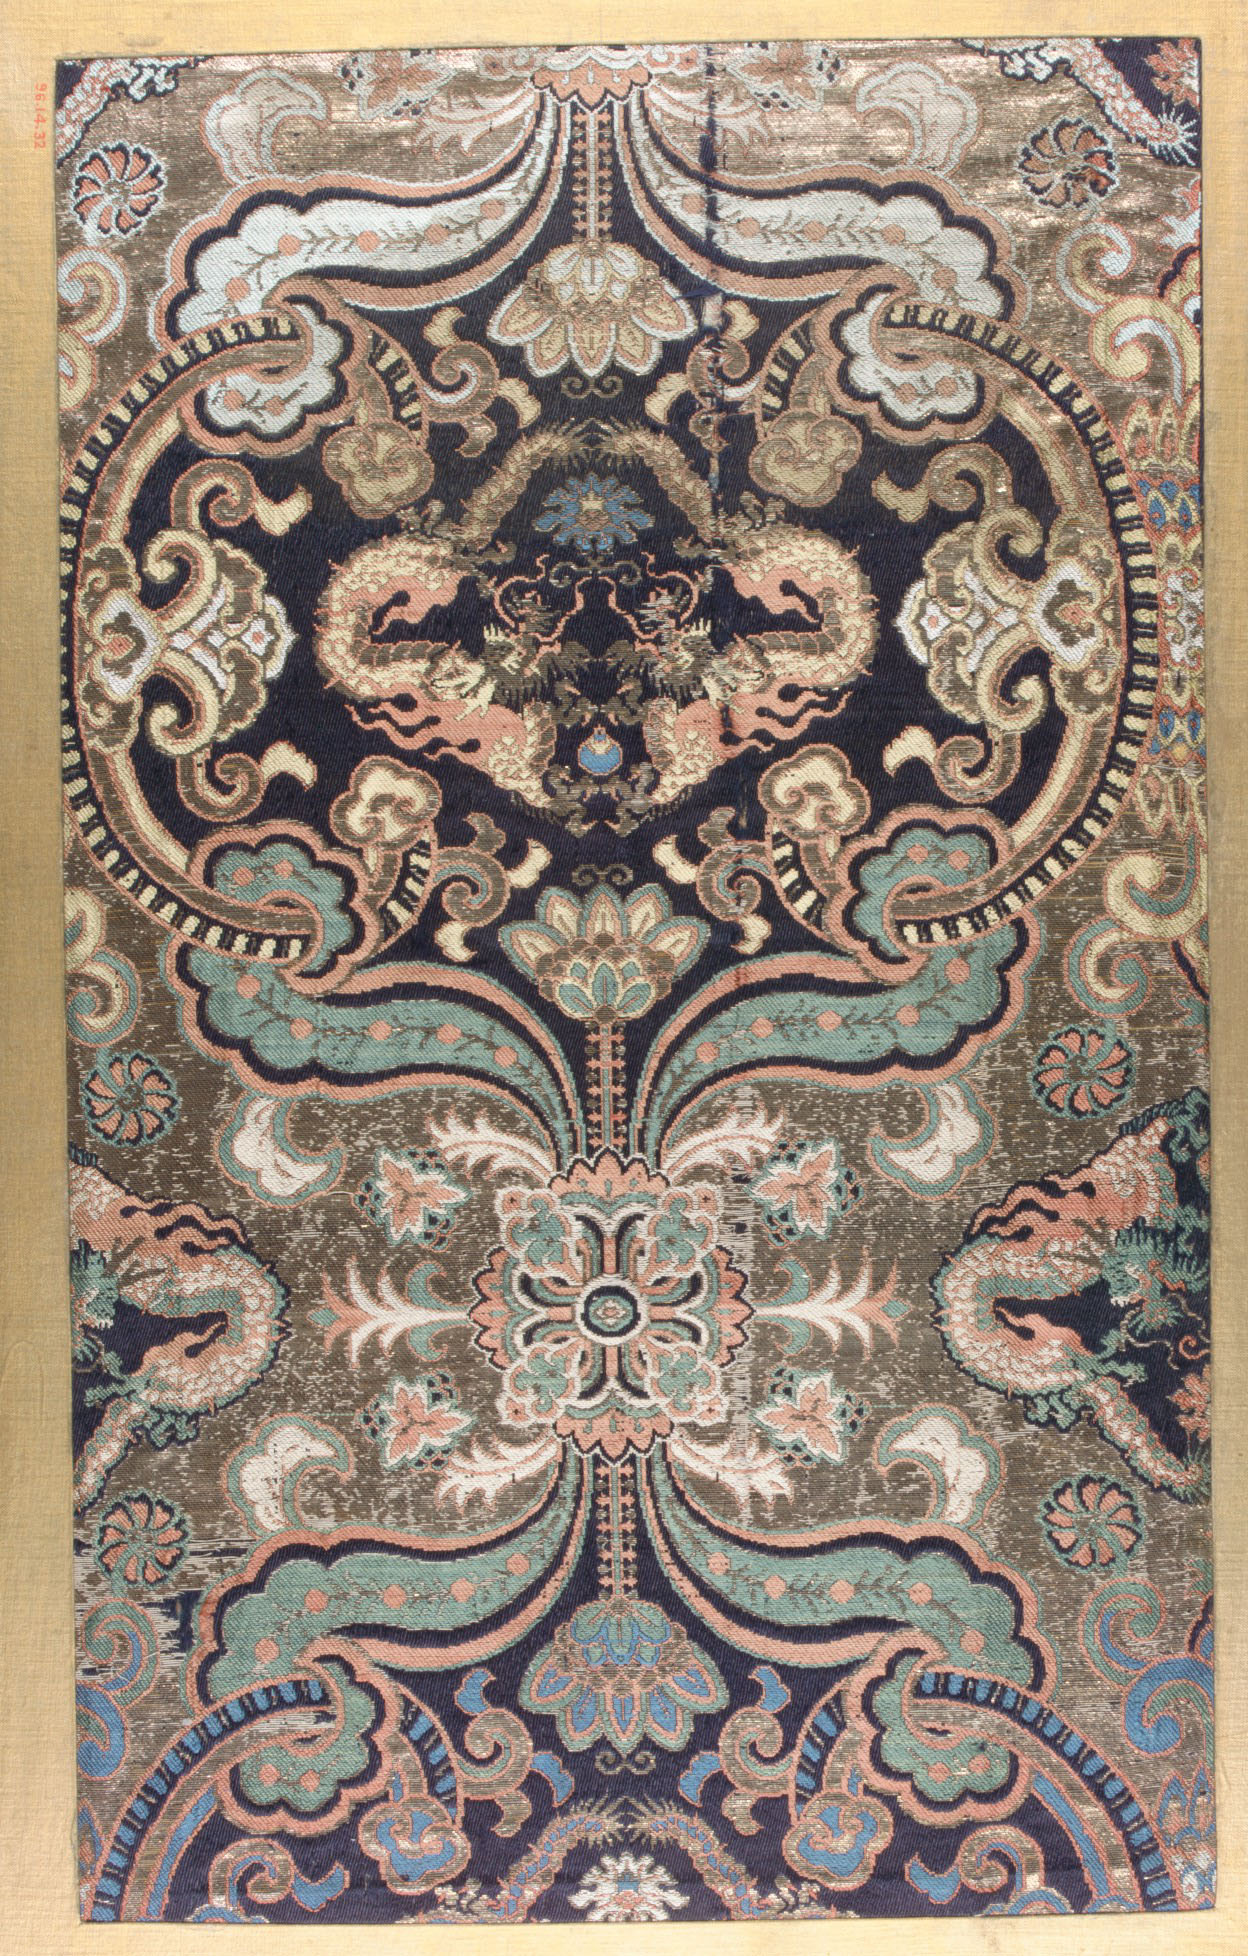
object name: piece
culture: japanese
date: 1701-1800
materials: metal thread, silk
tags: dragons